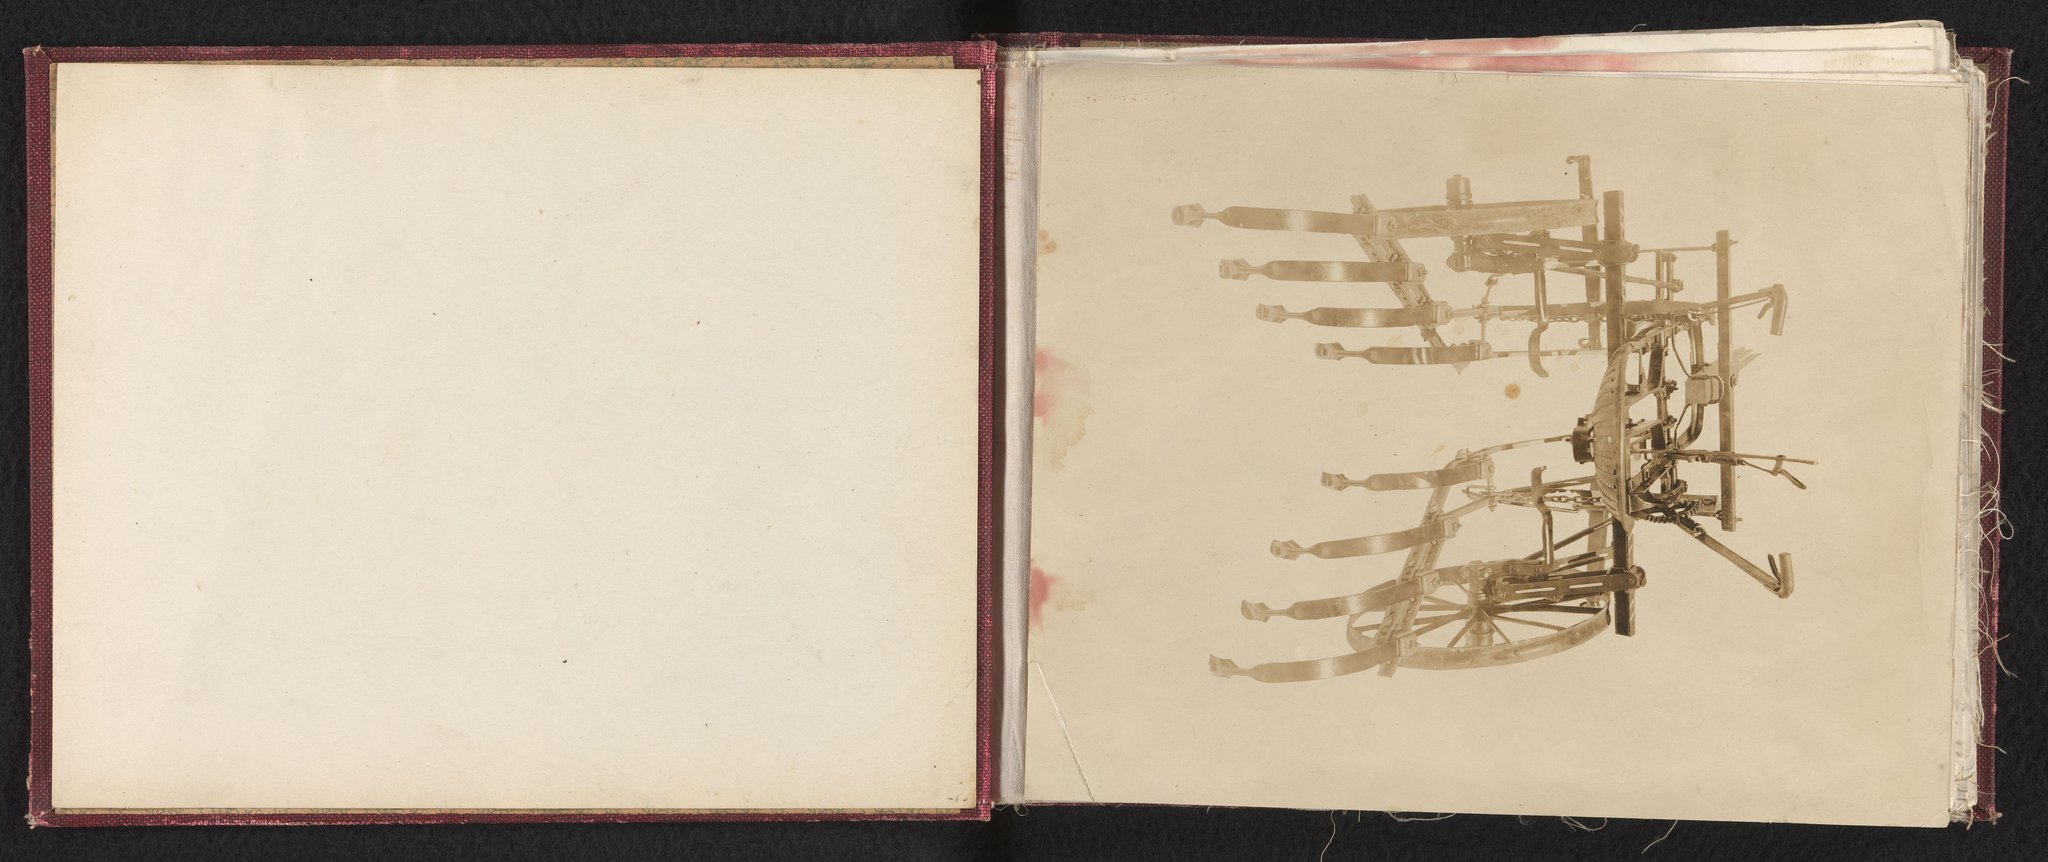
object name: photograph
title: Landbouwwerktuig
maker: lewis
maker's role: fotograaf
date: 1915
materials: paper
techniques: gelatin silver print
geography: utica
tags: agricultural implements